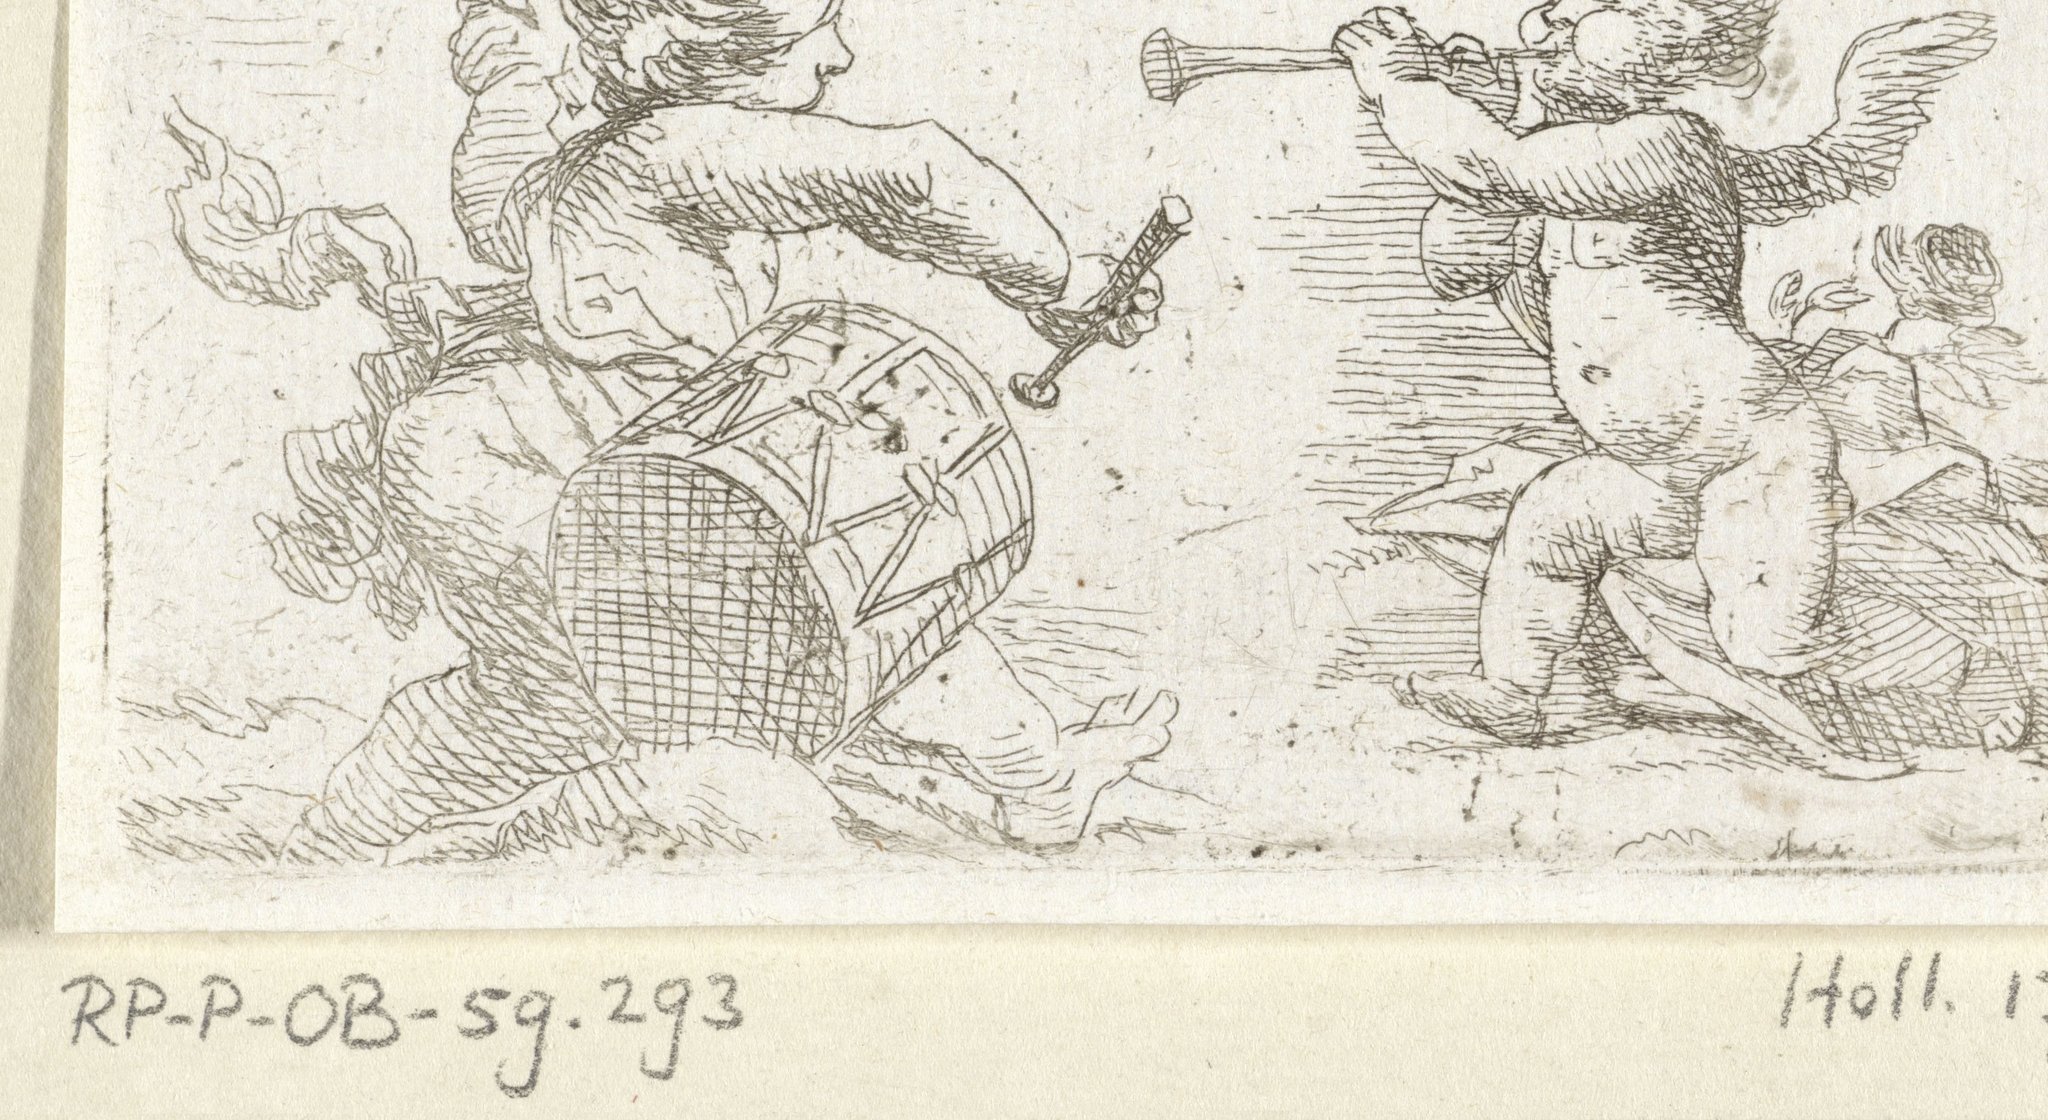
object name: print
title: Twee musicerende putti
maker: cornelis schut (i)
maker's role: draughtsman, print maker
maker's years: 1597-1655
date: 1618-1655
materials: paper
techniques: etching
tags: drum (musical instrument), cupids: 'amores', 'amoretti', 'putti', flute, aulos, tibia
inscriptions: collector's mark: Lugt 240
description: Een putto slaat op een trommel, een andere blaast op een fluit.